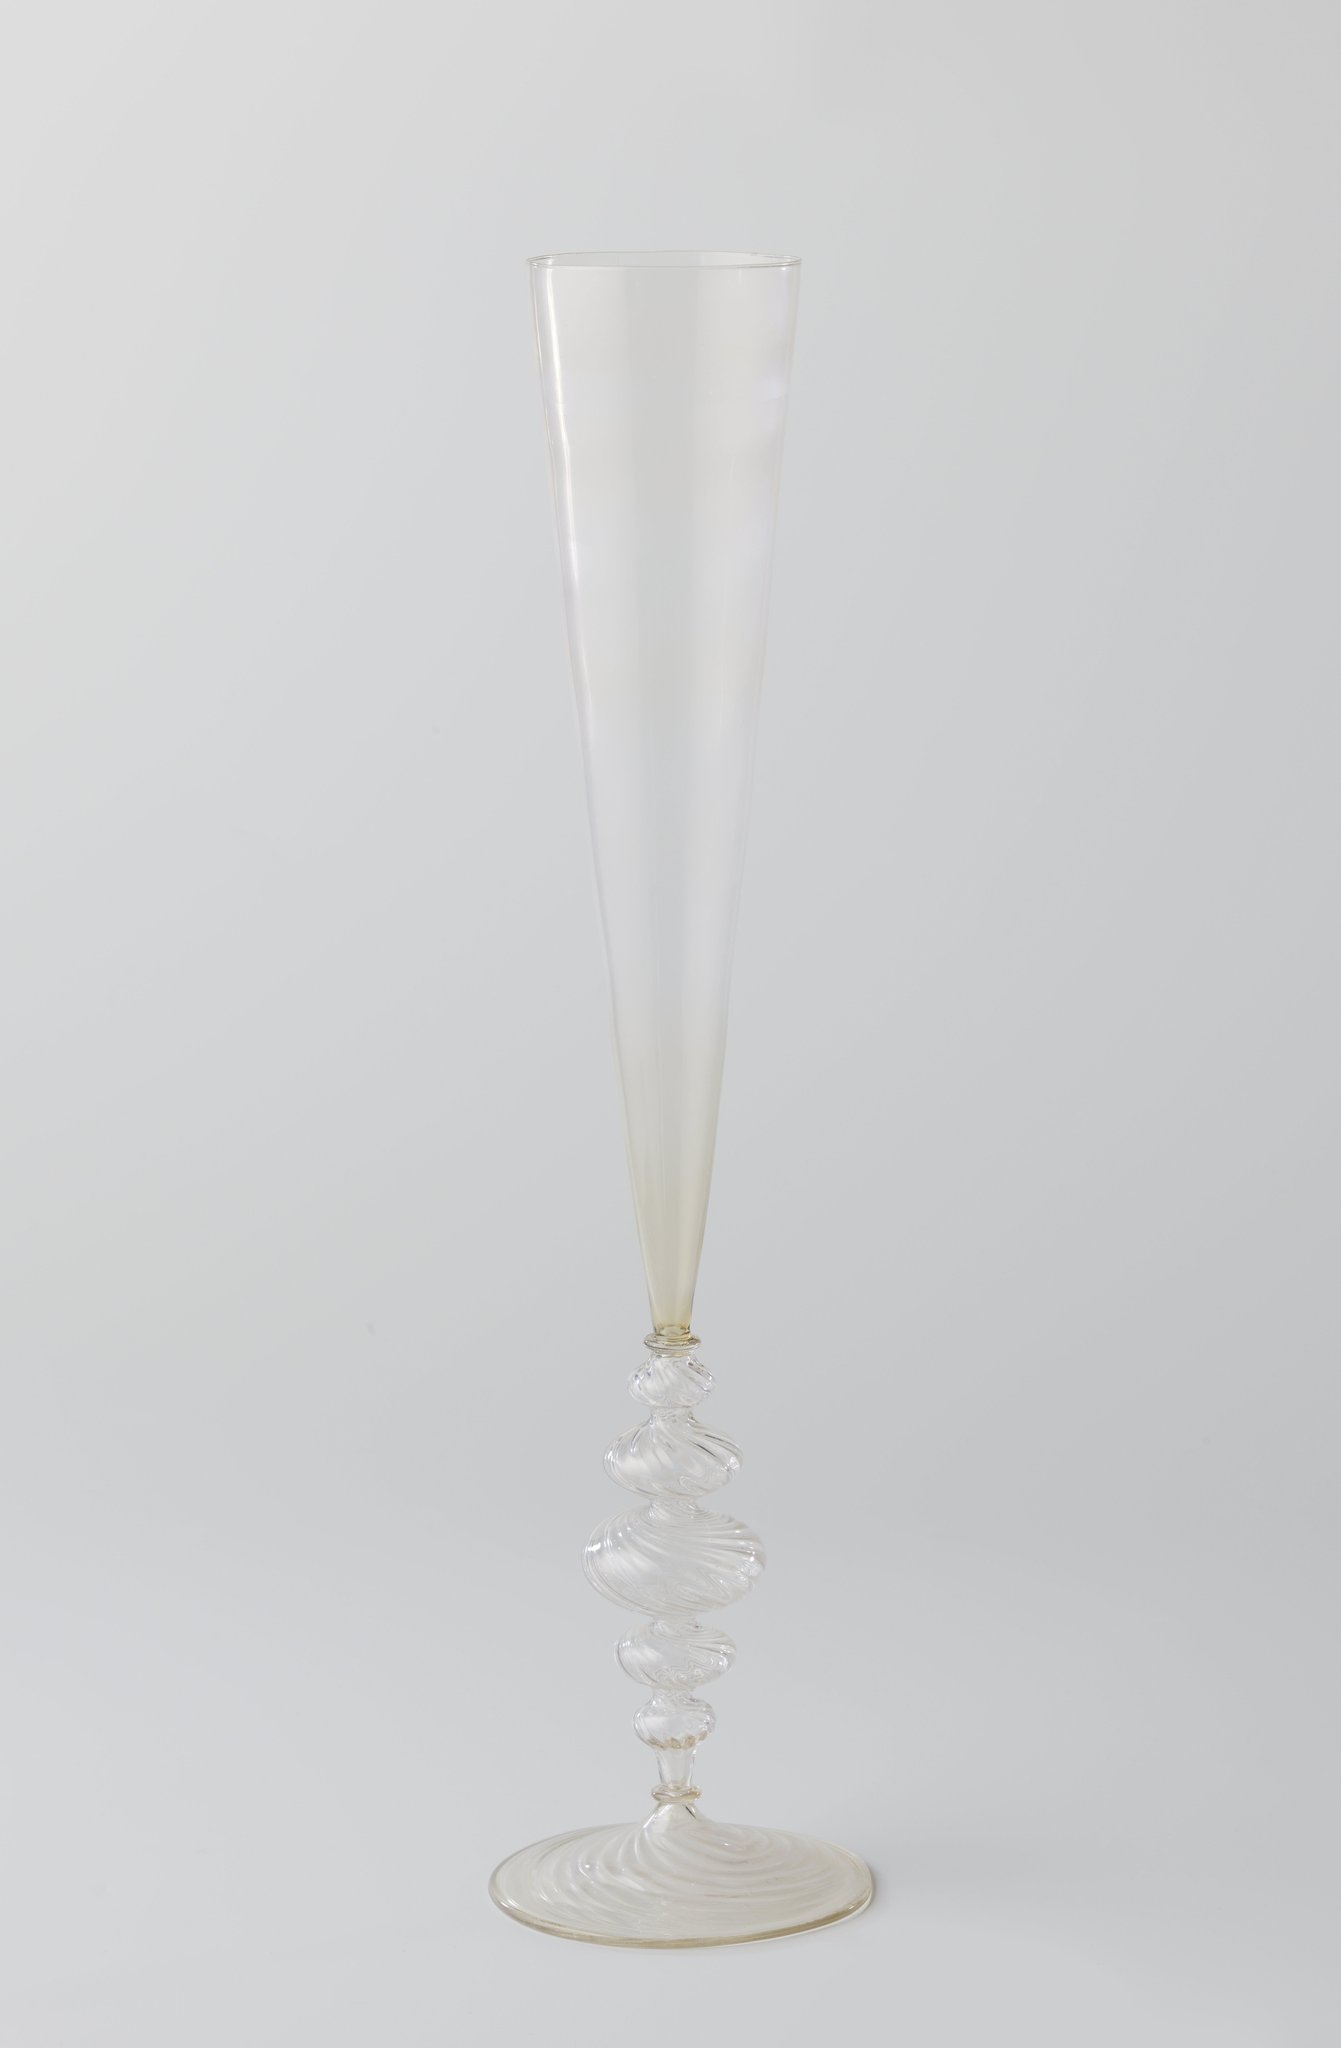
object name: flute glass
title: Fluitglas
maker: c.h.f. müller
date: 1875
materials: glass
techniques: façon de venise, glassblowing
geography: hamburg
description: Hoge conische voet met in de vorm geblazen getordeerde ribben. De holle stam opgebouwd uit vijf afgeplatte bollen met optisch geblazen, getordeerde ribben. Boven en onder de stam een gladde ring. Hoge trechtervormige kelk.